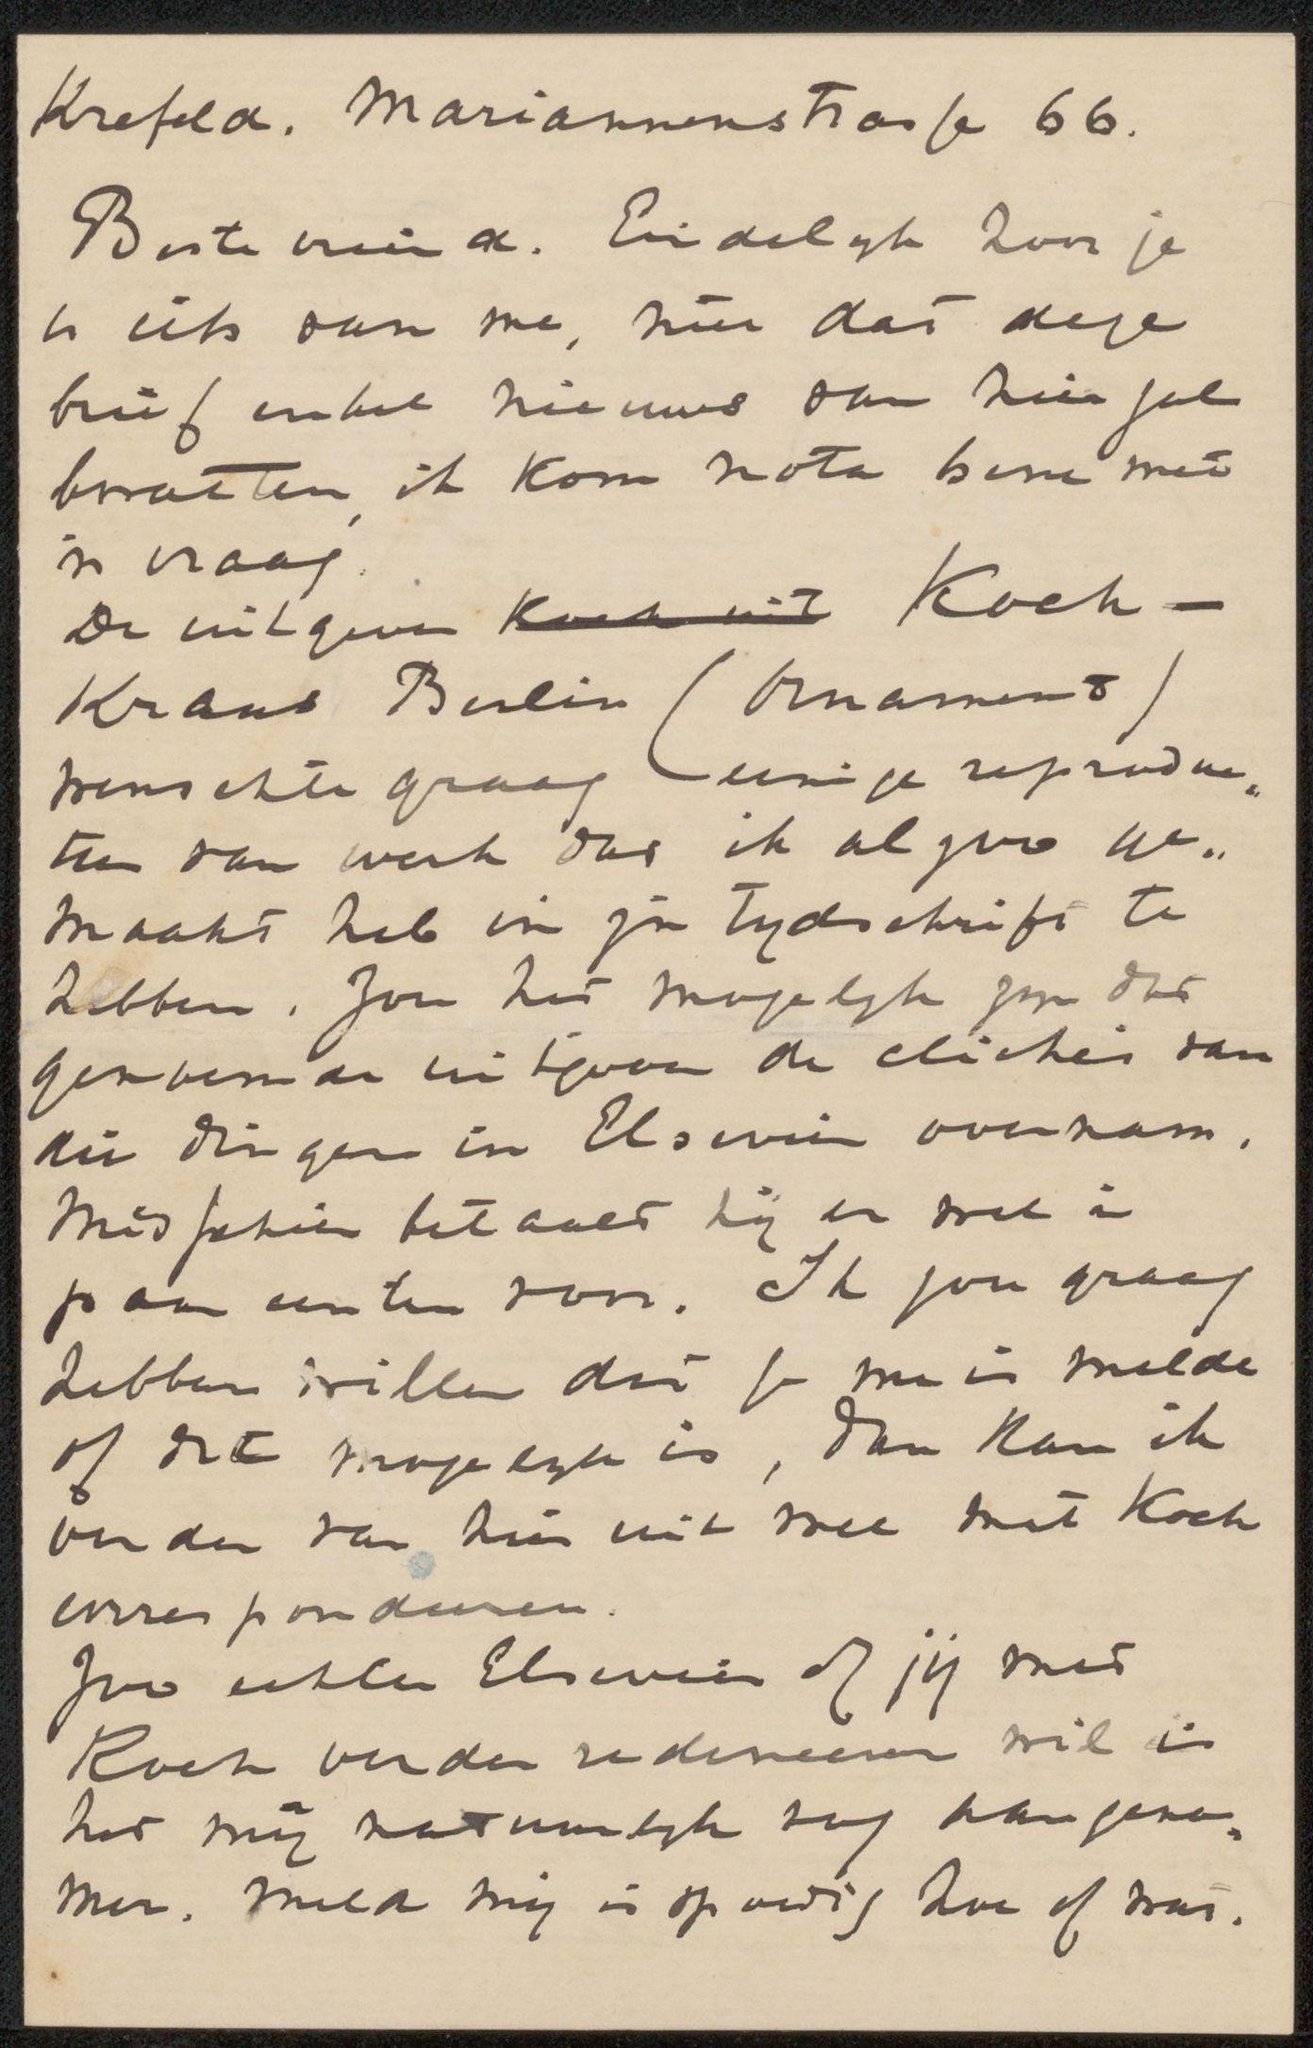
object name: letter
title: Brief aan Philip Zilcken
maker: johan thorn prikker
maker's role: draughtsman, print maker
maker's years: 1868-1932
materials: ink, paper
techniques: pen, writing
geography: krefeld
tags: friedrich deneken, the hague, painter, draughtsman, philip zilcken, applied arts, arts and crafts; industrial design, painting (including book-illumination, miniature-painting), printed matter, germany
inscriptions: collector's mark: ‘RPK’